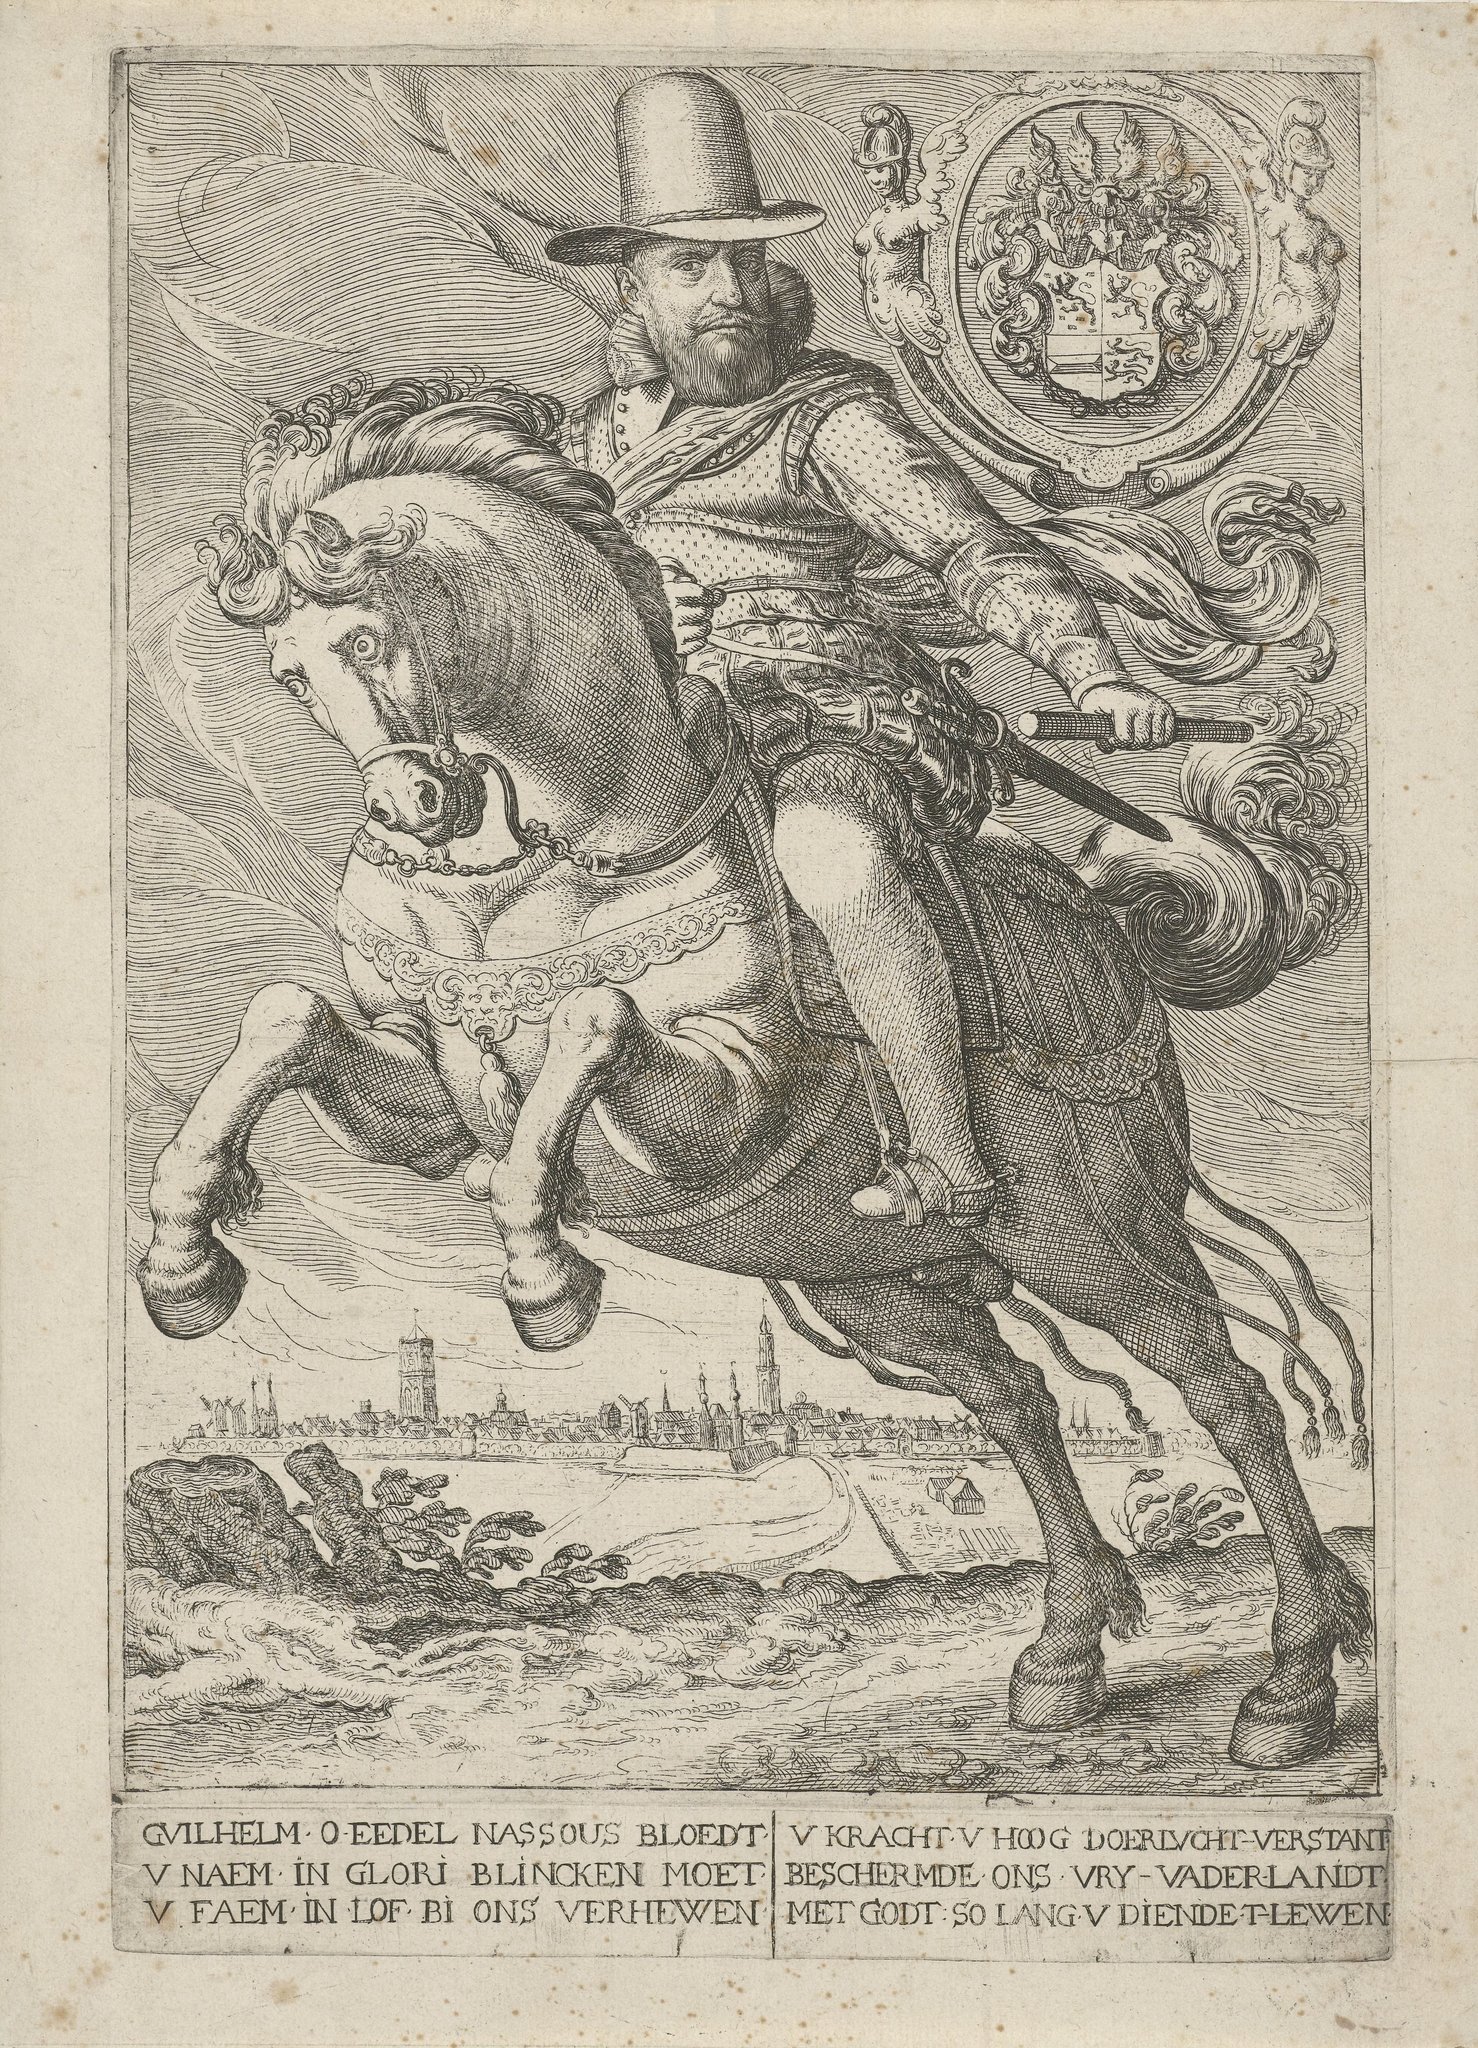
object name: print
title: Ruiterportret van Willem Lodewijk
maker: pieter feddes van harlingen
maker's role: painter, print maker, publisher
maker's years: 1586-1623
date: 1611-1623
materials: paper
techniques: etching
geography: friesland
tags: willem lodewijk graaf van nassau-dillenburg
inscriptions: collector's mark: Lugt 240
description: Willem Lodewijk, graaf van Nassau, stadhouder van Friesland, zit met commandostaf in de linker hand op een steigerend paard. Rechtsboven zijn wapen. Op de achtergrond de stad Leeuwarden met links de Oldehove en rechts de Nieuwe Toren. Onder de voorstelling een Nederlands vers, van een tweede plaat gedrukt.